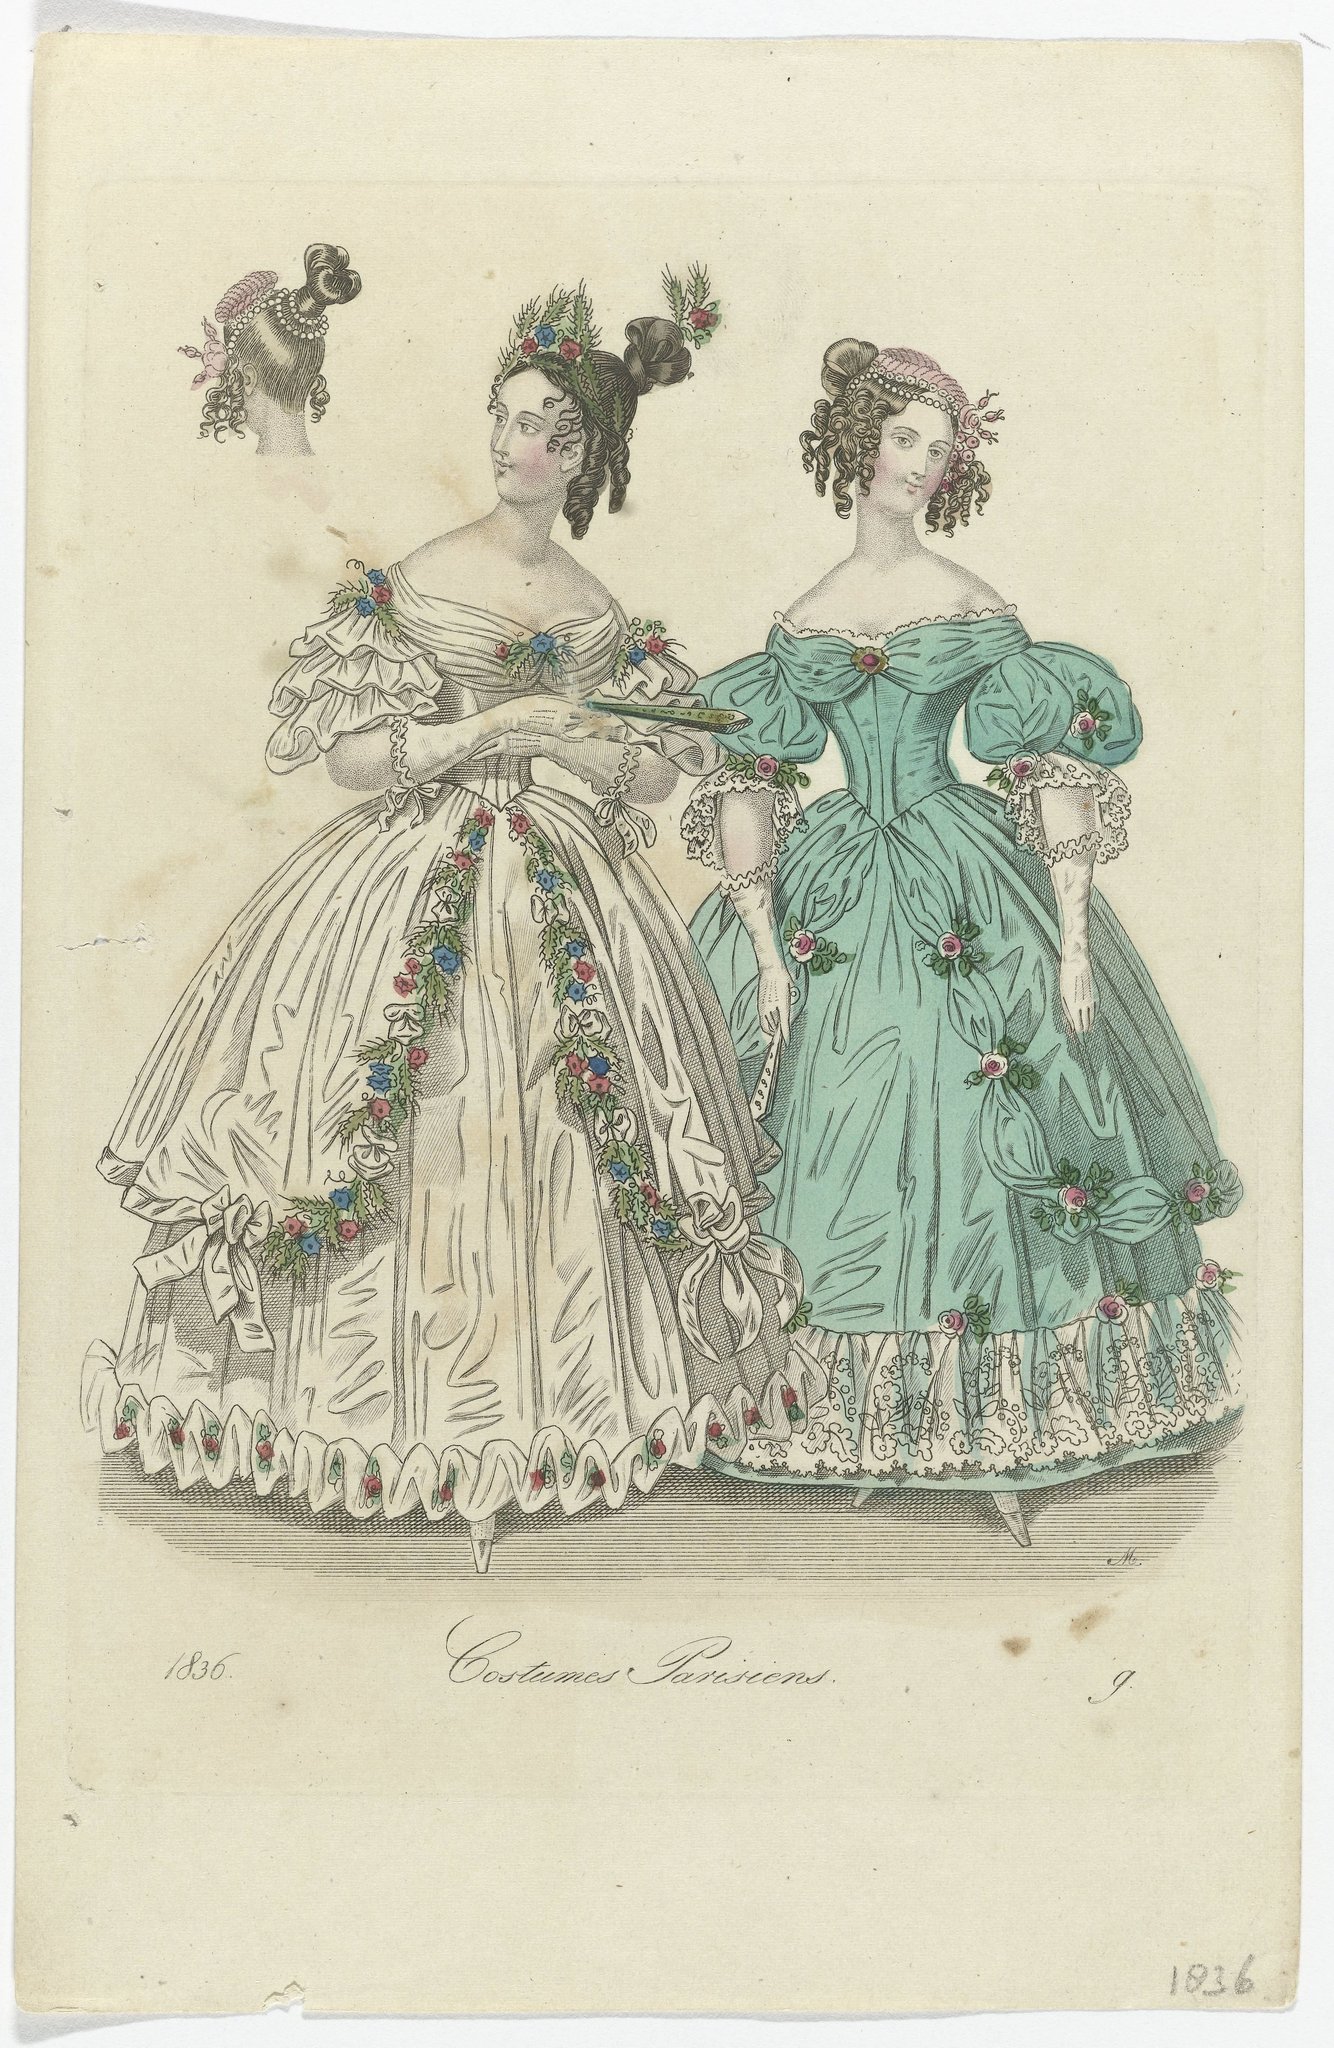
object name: fashion print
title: Journal des Dames et des Modes, editie Frankfurt 1836, Costumes Parisiens, (9)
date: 1836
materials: paper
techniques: engraving, hand coloring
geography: frankfurt am main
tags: gloves, mittens (long gloves) (+ women's clothes), dress, gown: ball gown (+ women's clothes), styles of hairdress - aa - ~ women, fashion plates, fan (+ women's clothes)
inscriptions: title: ‘Costumes Parisiens’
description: Twee vrouwen in 'toilettes' voor een bal. Links: baljapon met open overrok versierd met bloemen. Kapsel versierd met bloemen en aren. Waaier en lange handschoenen. Rechts: baljapon versierd met bloemen. Mouwen en zoom versierd met gerimpelde strook stof met bloemmotief. Kapsel versierd met kralensnoer en bloemen; waarvan de achterzijde ook is weergegeven. Prent uit het modetijdschrift Journal des Dames et des Modes (Frankfurt-am-Main, 1798-1848). De dame links is waarschijnlijk gekopieerd naar prent No. 1229 (?) uit het modetijdschrift Petit Courier des Dames.